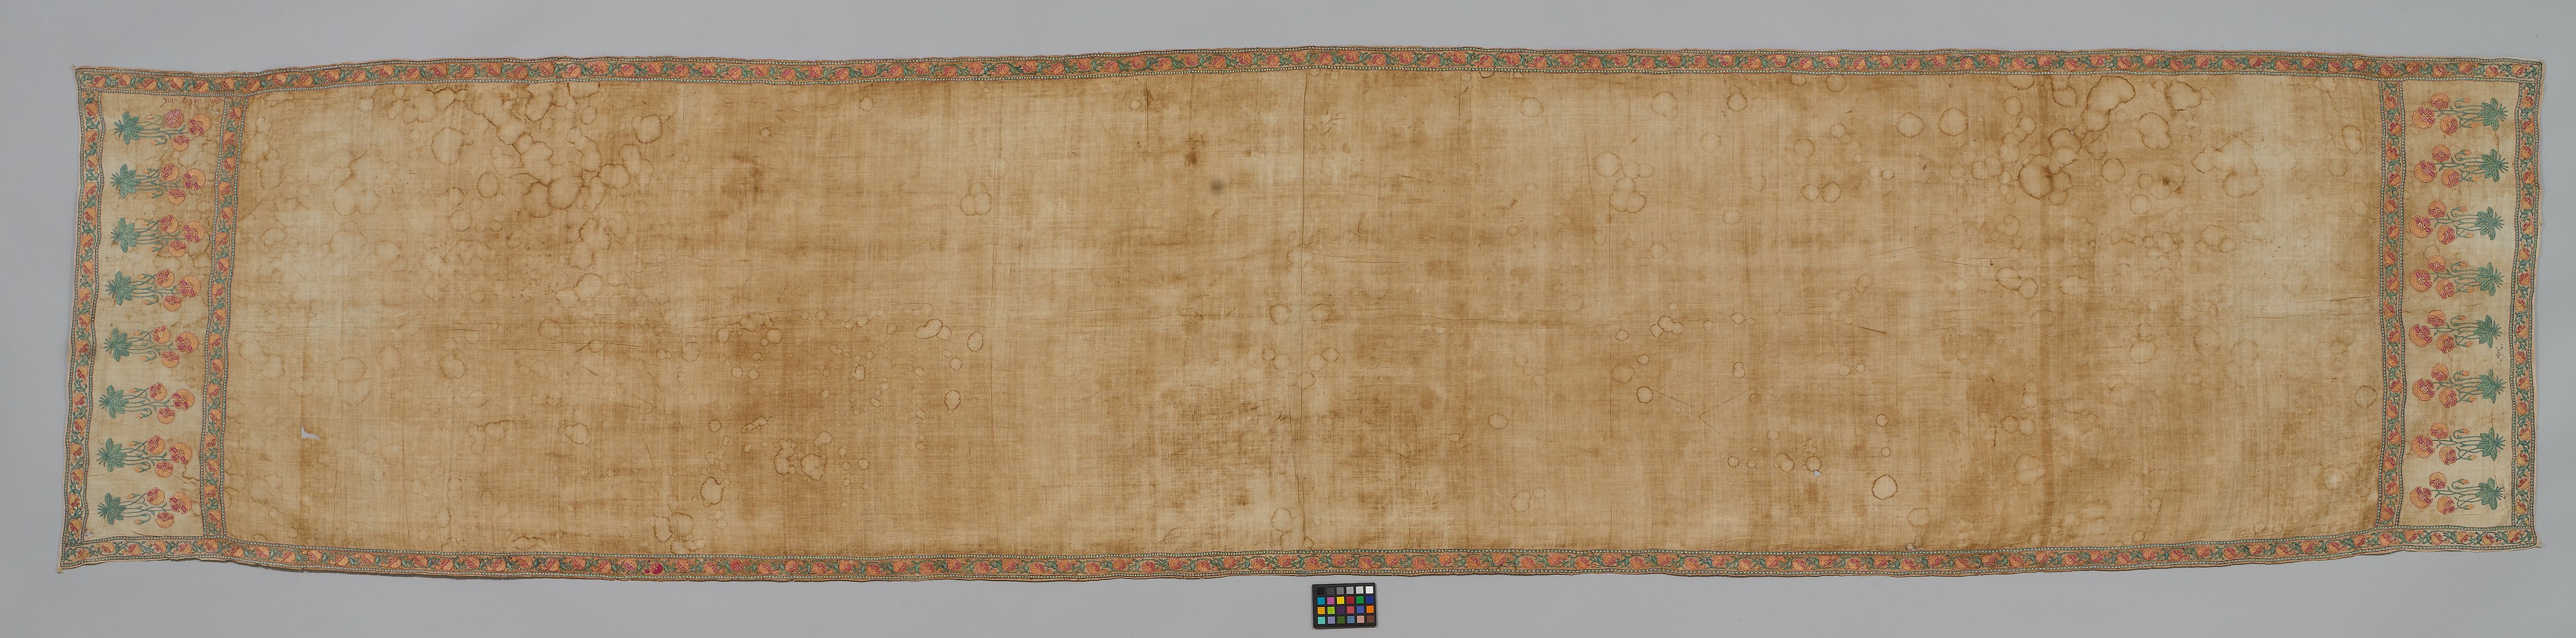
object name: sash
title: Sash (<Patka>) with a Floral Border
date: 1651-1700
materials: cotton, silk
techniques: embroidery, weave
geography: india